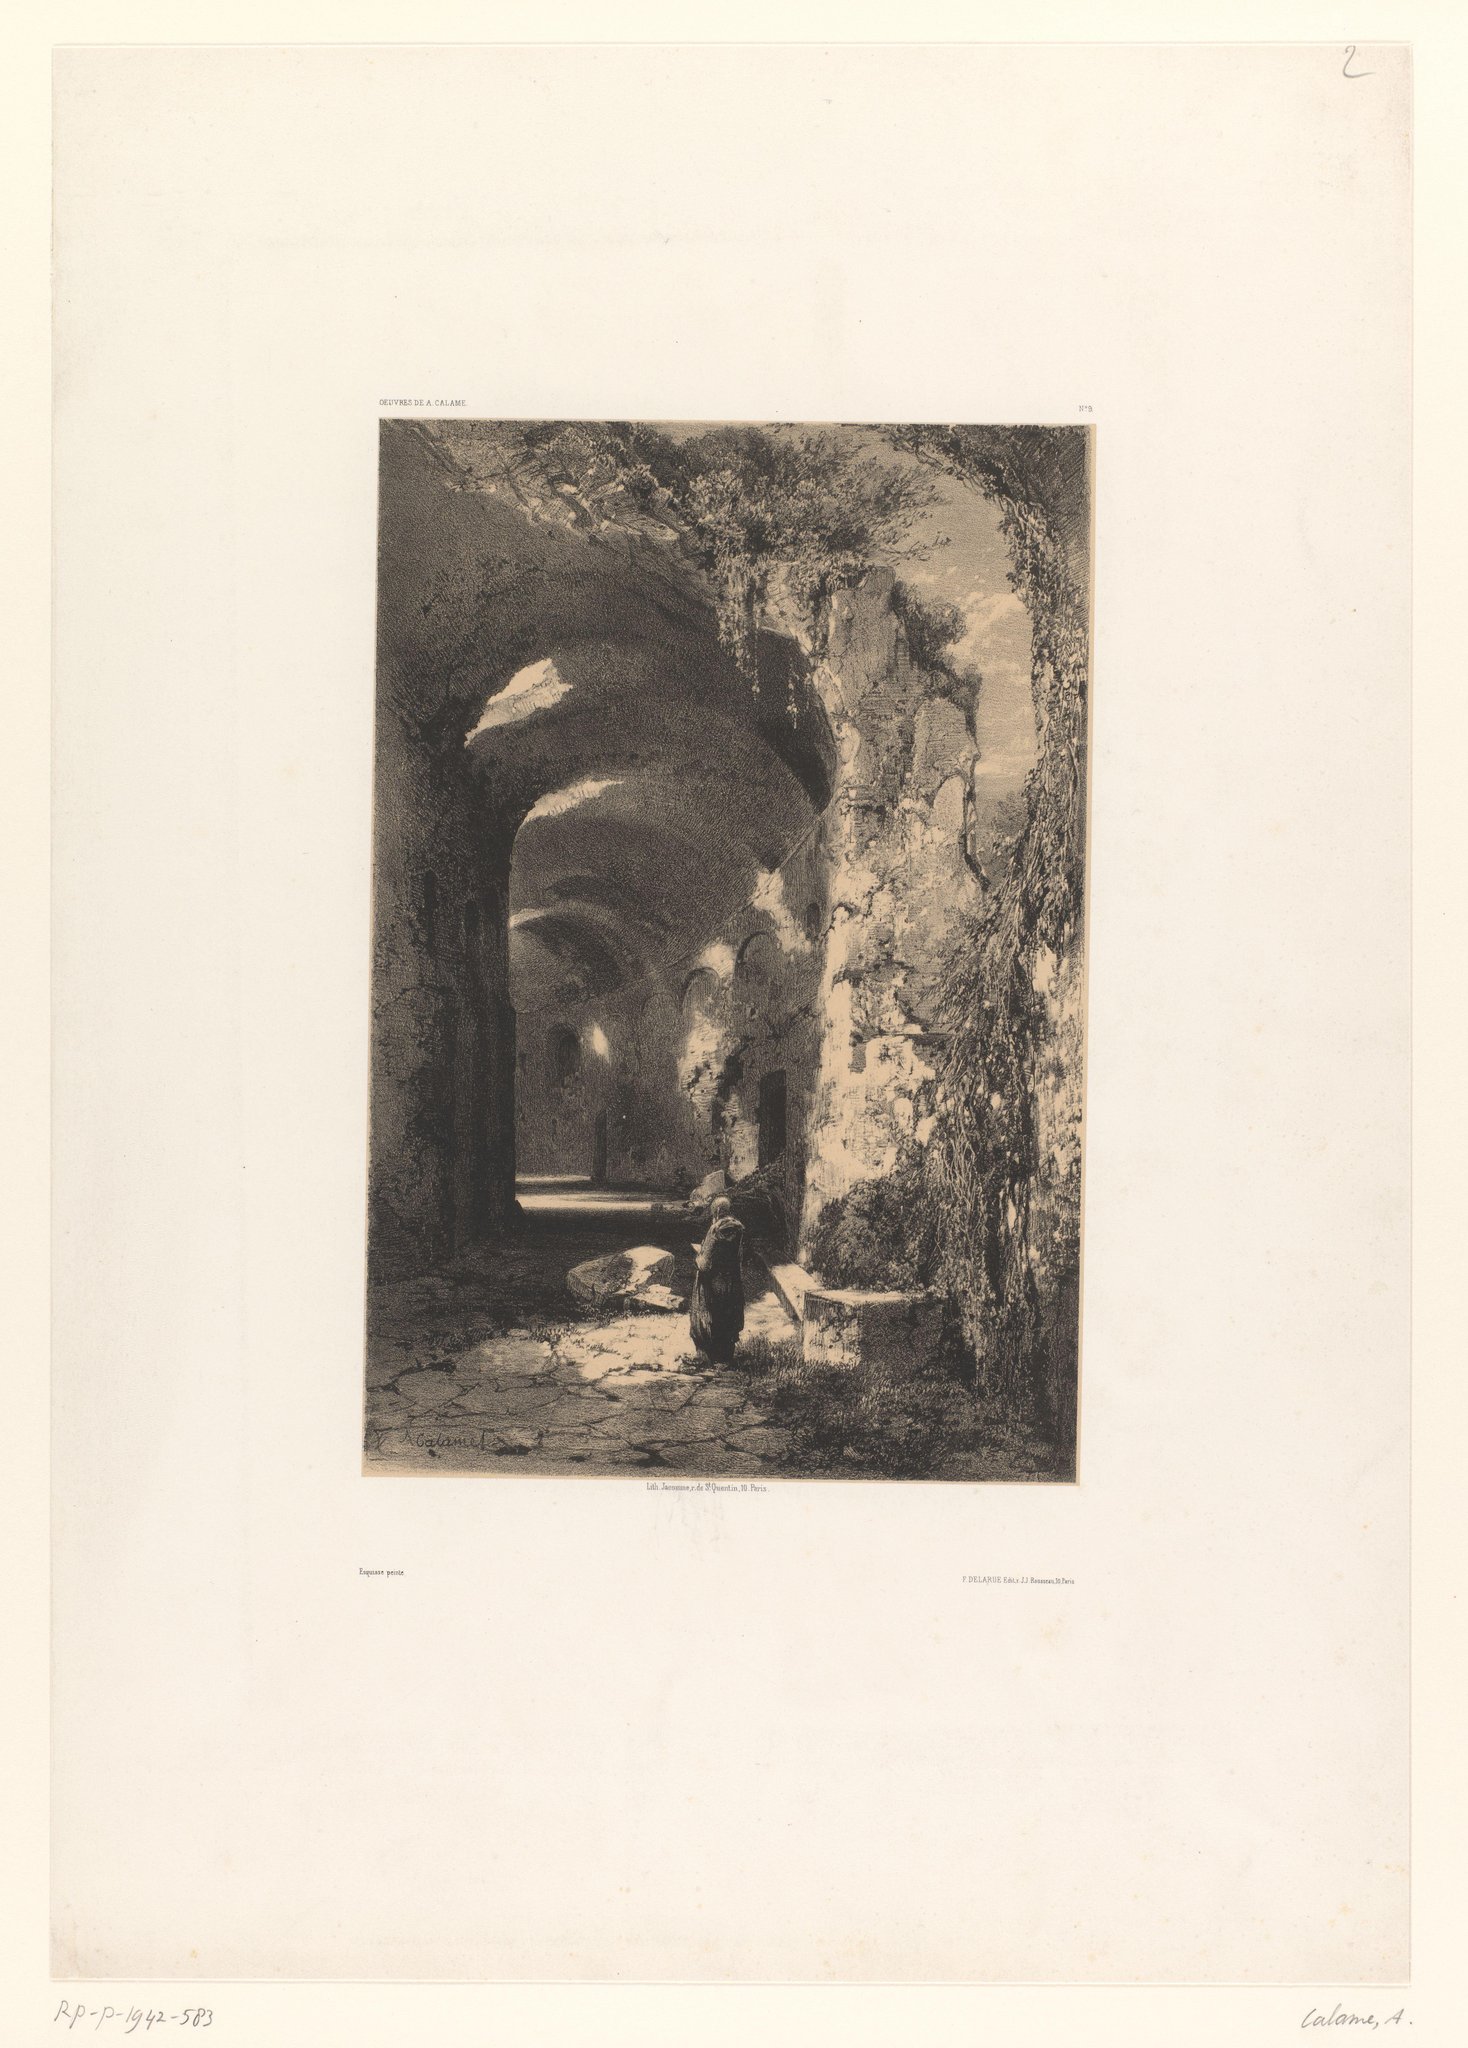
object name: print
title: Oeuvres de A. Calame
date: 1852-1855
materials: paper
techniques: lithograph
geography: paris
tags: parts of church interior: ambulatory, monk(s), friar(s), ruin of church, monastery, etc.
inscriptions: collector's mark: Lugt 2228a